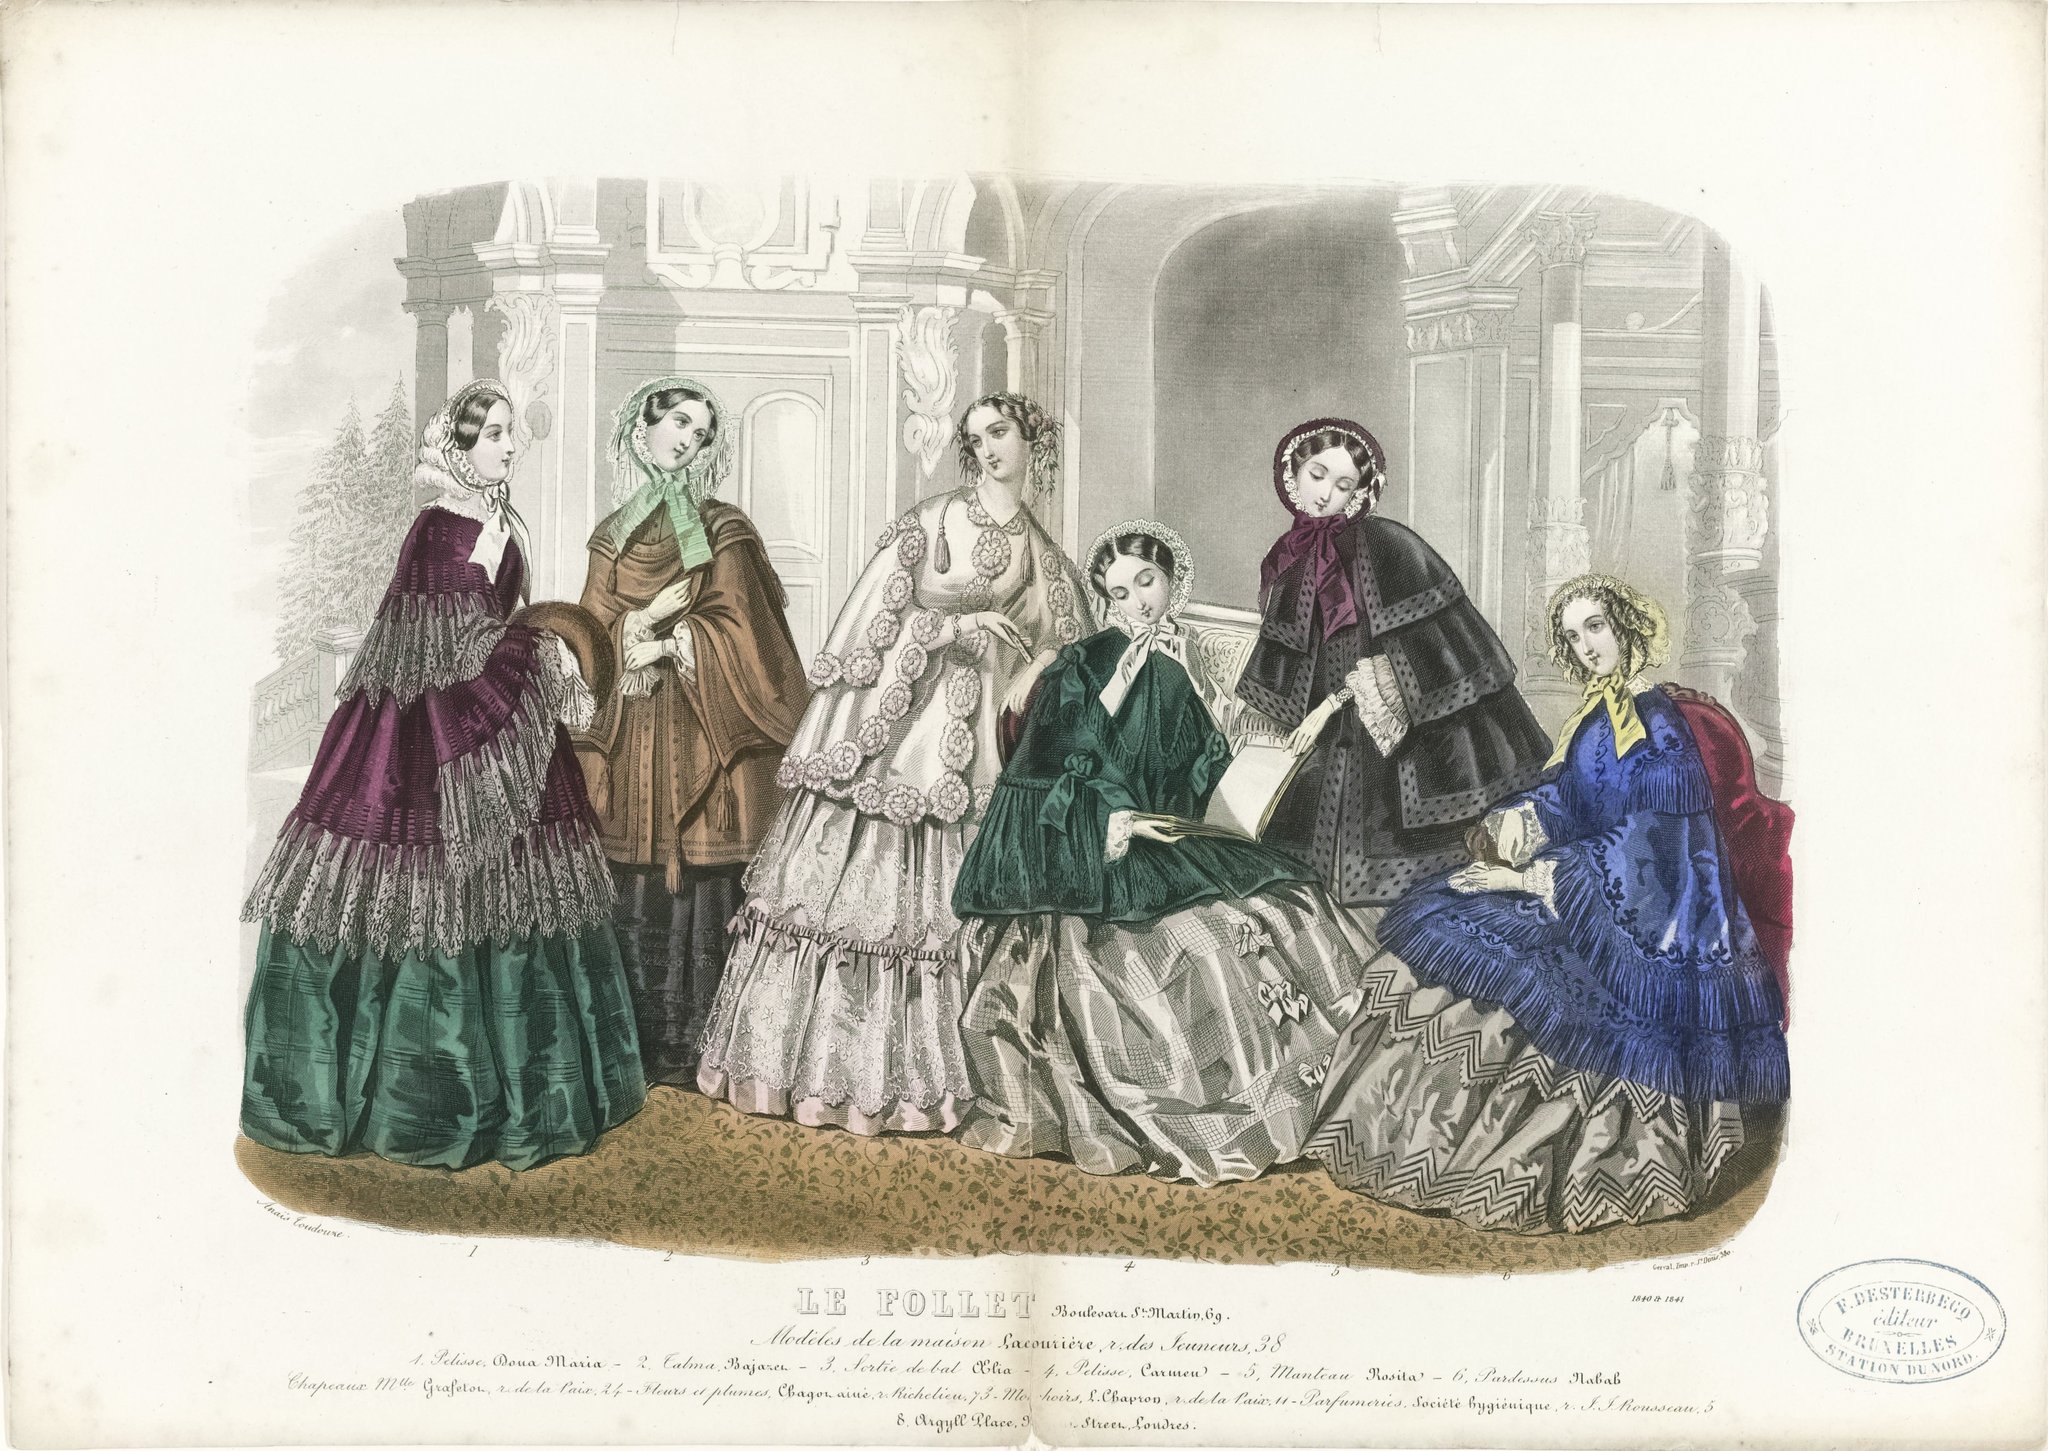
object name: fashion print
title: Le Follet, 1853, No. 1840 & 1841 (?): Modeles de la maison Lacourièr (...)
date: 1853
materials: paper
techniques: engraving, hand coloring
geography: paris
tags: bow (ornamental part of clothing) (+ women's clothes), flowers, handkerchief (+ women's clothes), dress, gown: ball gown (+ women's clothes), coat (+ women's clothes), cape (pelisse) (+ women's clothes), coat (short coat) (+ women's clothes), dress, gown (pardessus) (+ women's clothes), fashion plates, head-gear: hat (+ women's clothes), skirt (+ women's clothes), muff (+ fur used for clothes)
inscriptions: stamp: ‘F. DESTERBECQ / éditeur / BRUXELLES / STATION DU NORD.’, address: ‘Boulevart S.t Martin 69.’, caption: ‘Modeles de la maison Lacourière, r. des Jeuneurs, 38 / 1. Pelisse, Dona Maria - 2. Talma, Bajazet - 3. Sortie de bal Elia - 4. Pelisse, Carmen - 5, Manteau Rosita - 6. Pardessus Nabab Chapeaux Mlle Grafeton, r. de la Paix, 24 - Fleurs et plumes, Chagot ainé, r. Richelieu, 73 - Mouchoirs, L. Chapron, r. de la Paix, 11 - Parfumeries , Sociétè hygiénique, r. J.J. Rouseau, 5 8, Argyll Place 9 (...) Street, Londres.’, title: ‘LE FOLLET’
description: Zes vrouwen met verschillende jassen, genummerd één tot en met zes. 1. Pelisse van Dona Maria, 2. 'Talma' van Bajazet. 3. 'Sortie' voor een bal van Elia. 4. Pelisse van Carmen. 5. Mantel van Rosita. 6. Pardessus van Nabab. Hoeden van Grafetor. Hieronder enkele regels reclametekst voor verschillende producten. Prent uit het modetijdschrift Le Follet Courrier des Salons (novembre 1829- octobre 1882).